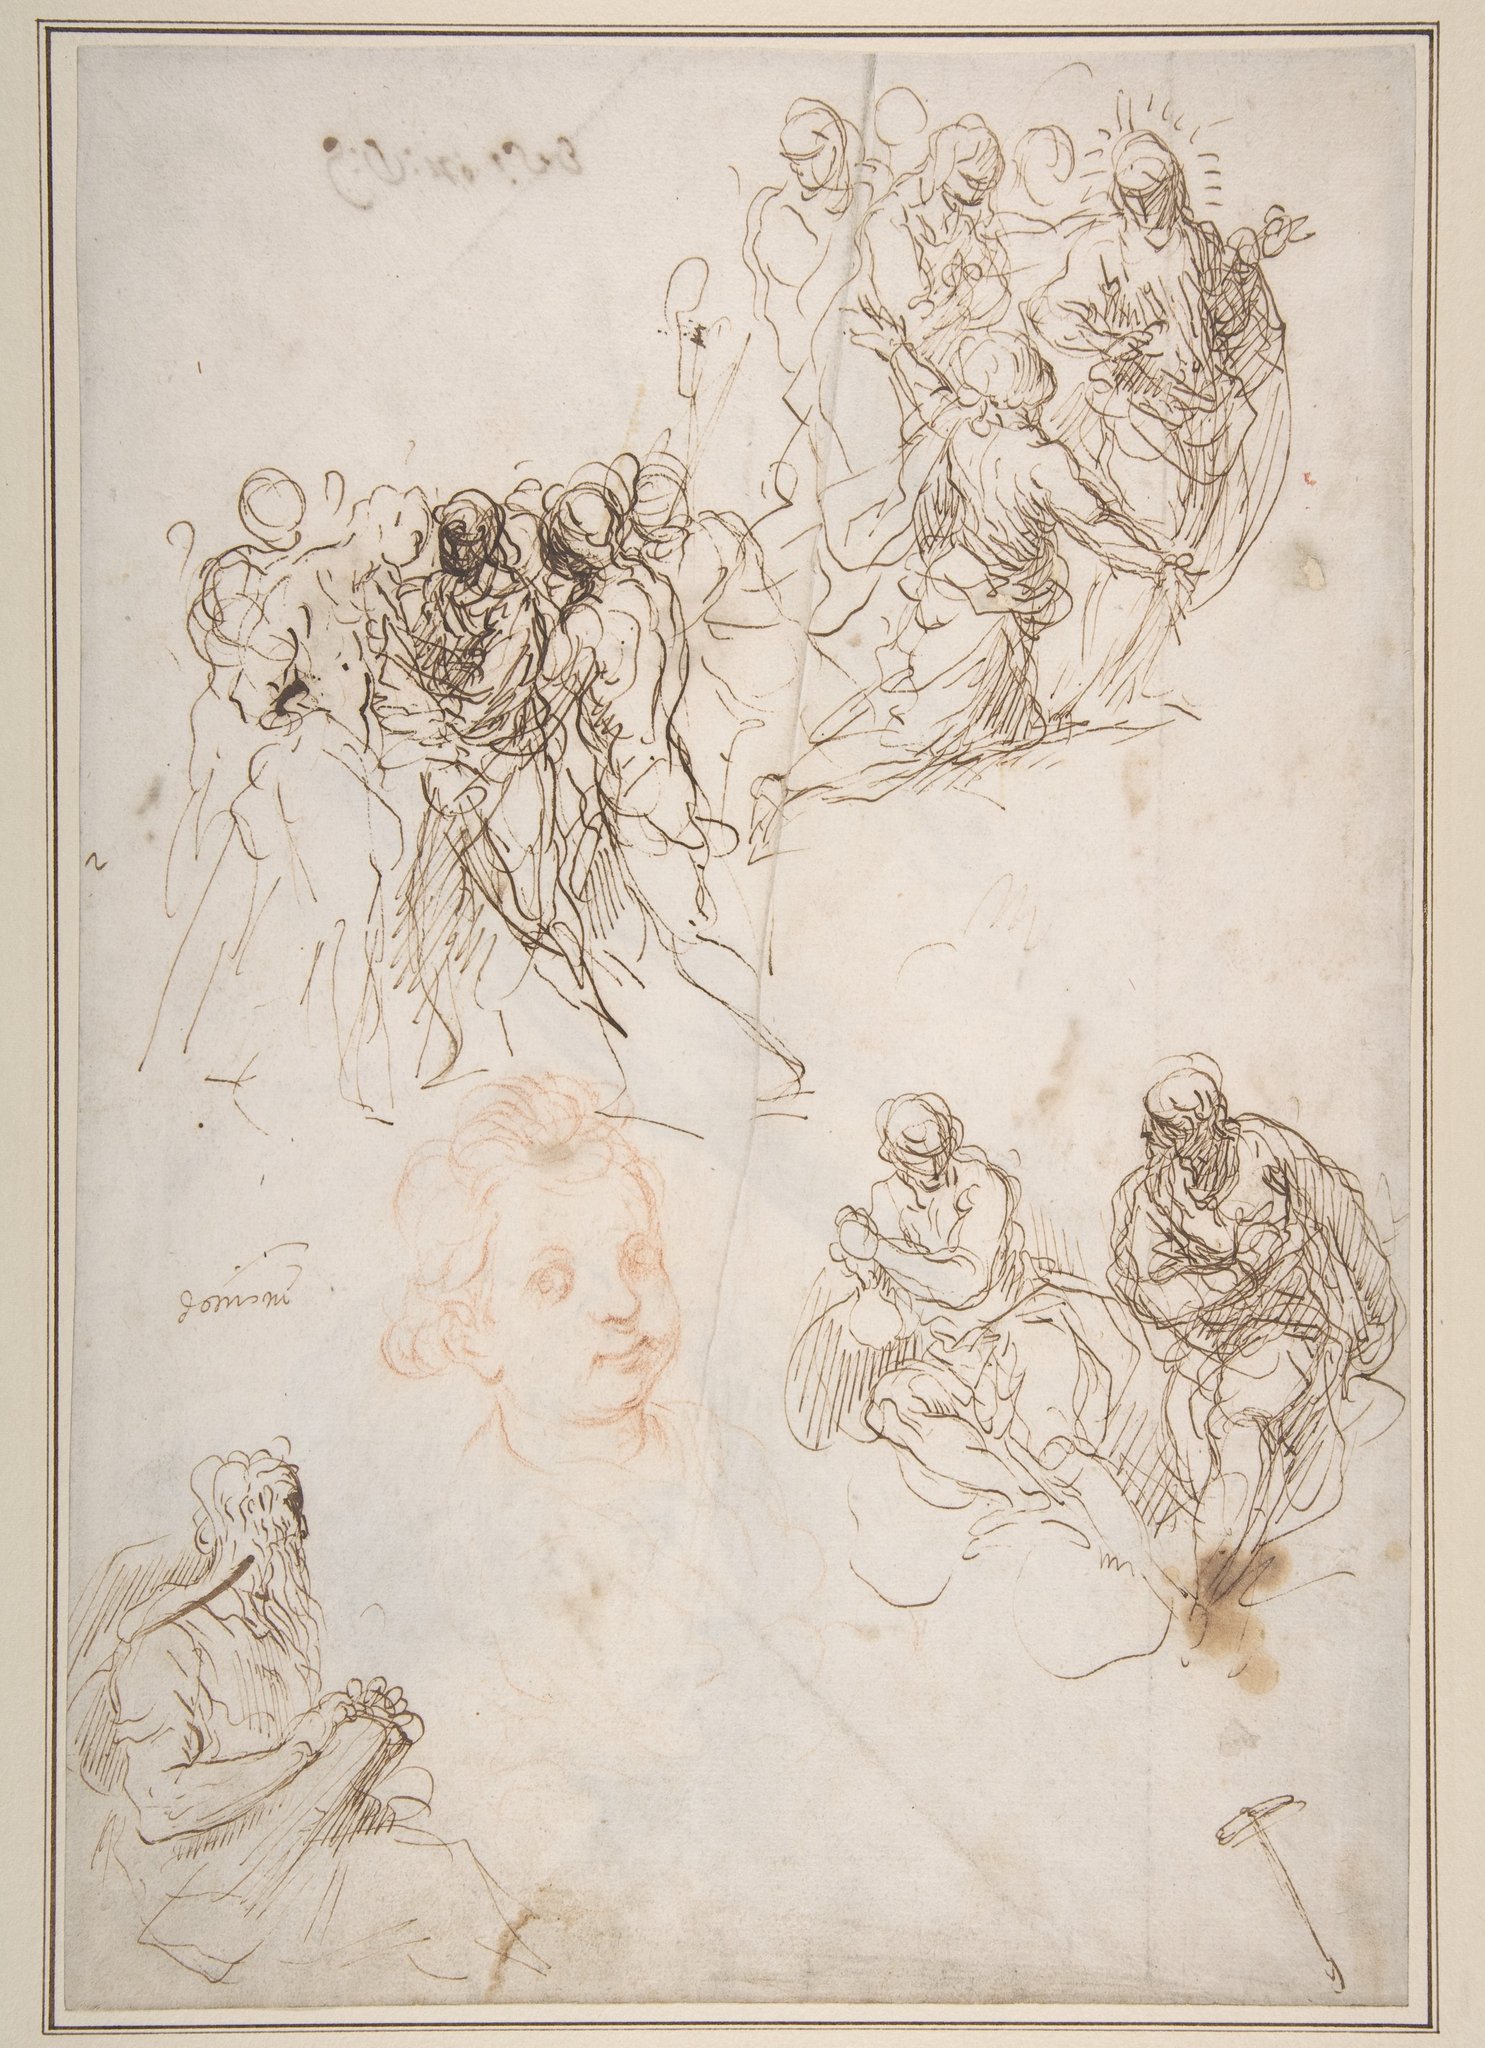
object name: drawing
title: Figure Studies: The Arrest of Christ?, Christ and the Canaanite Woman, Seated Male Figures, and Head of a Child (recto); Studies of an Arm, and of the Heads of an Old Man and Young Woman (verso)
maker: jacopo palma the younger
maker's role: artist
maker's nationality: italian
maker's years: 1543-1628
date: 1548-1628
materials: chalk, ink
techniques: pen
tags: heads,children,men,women,christ